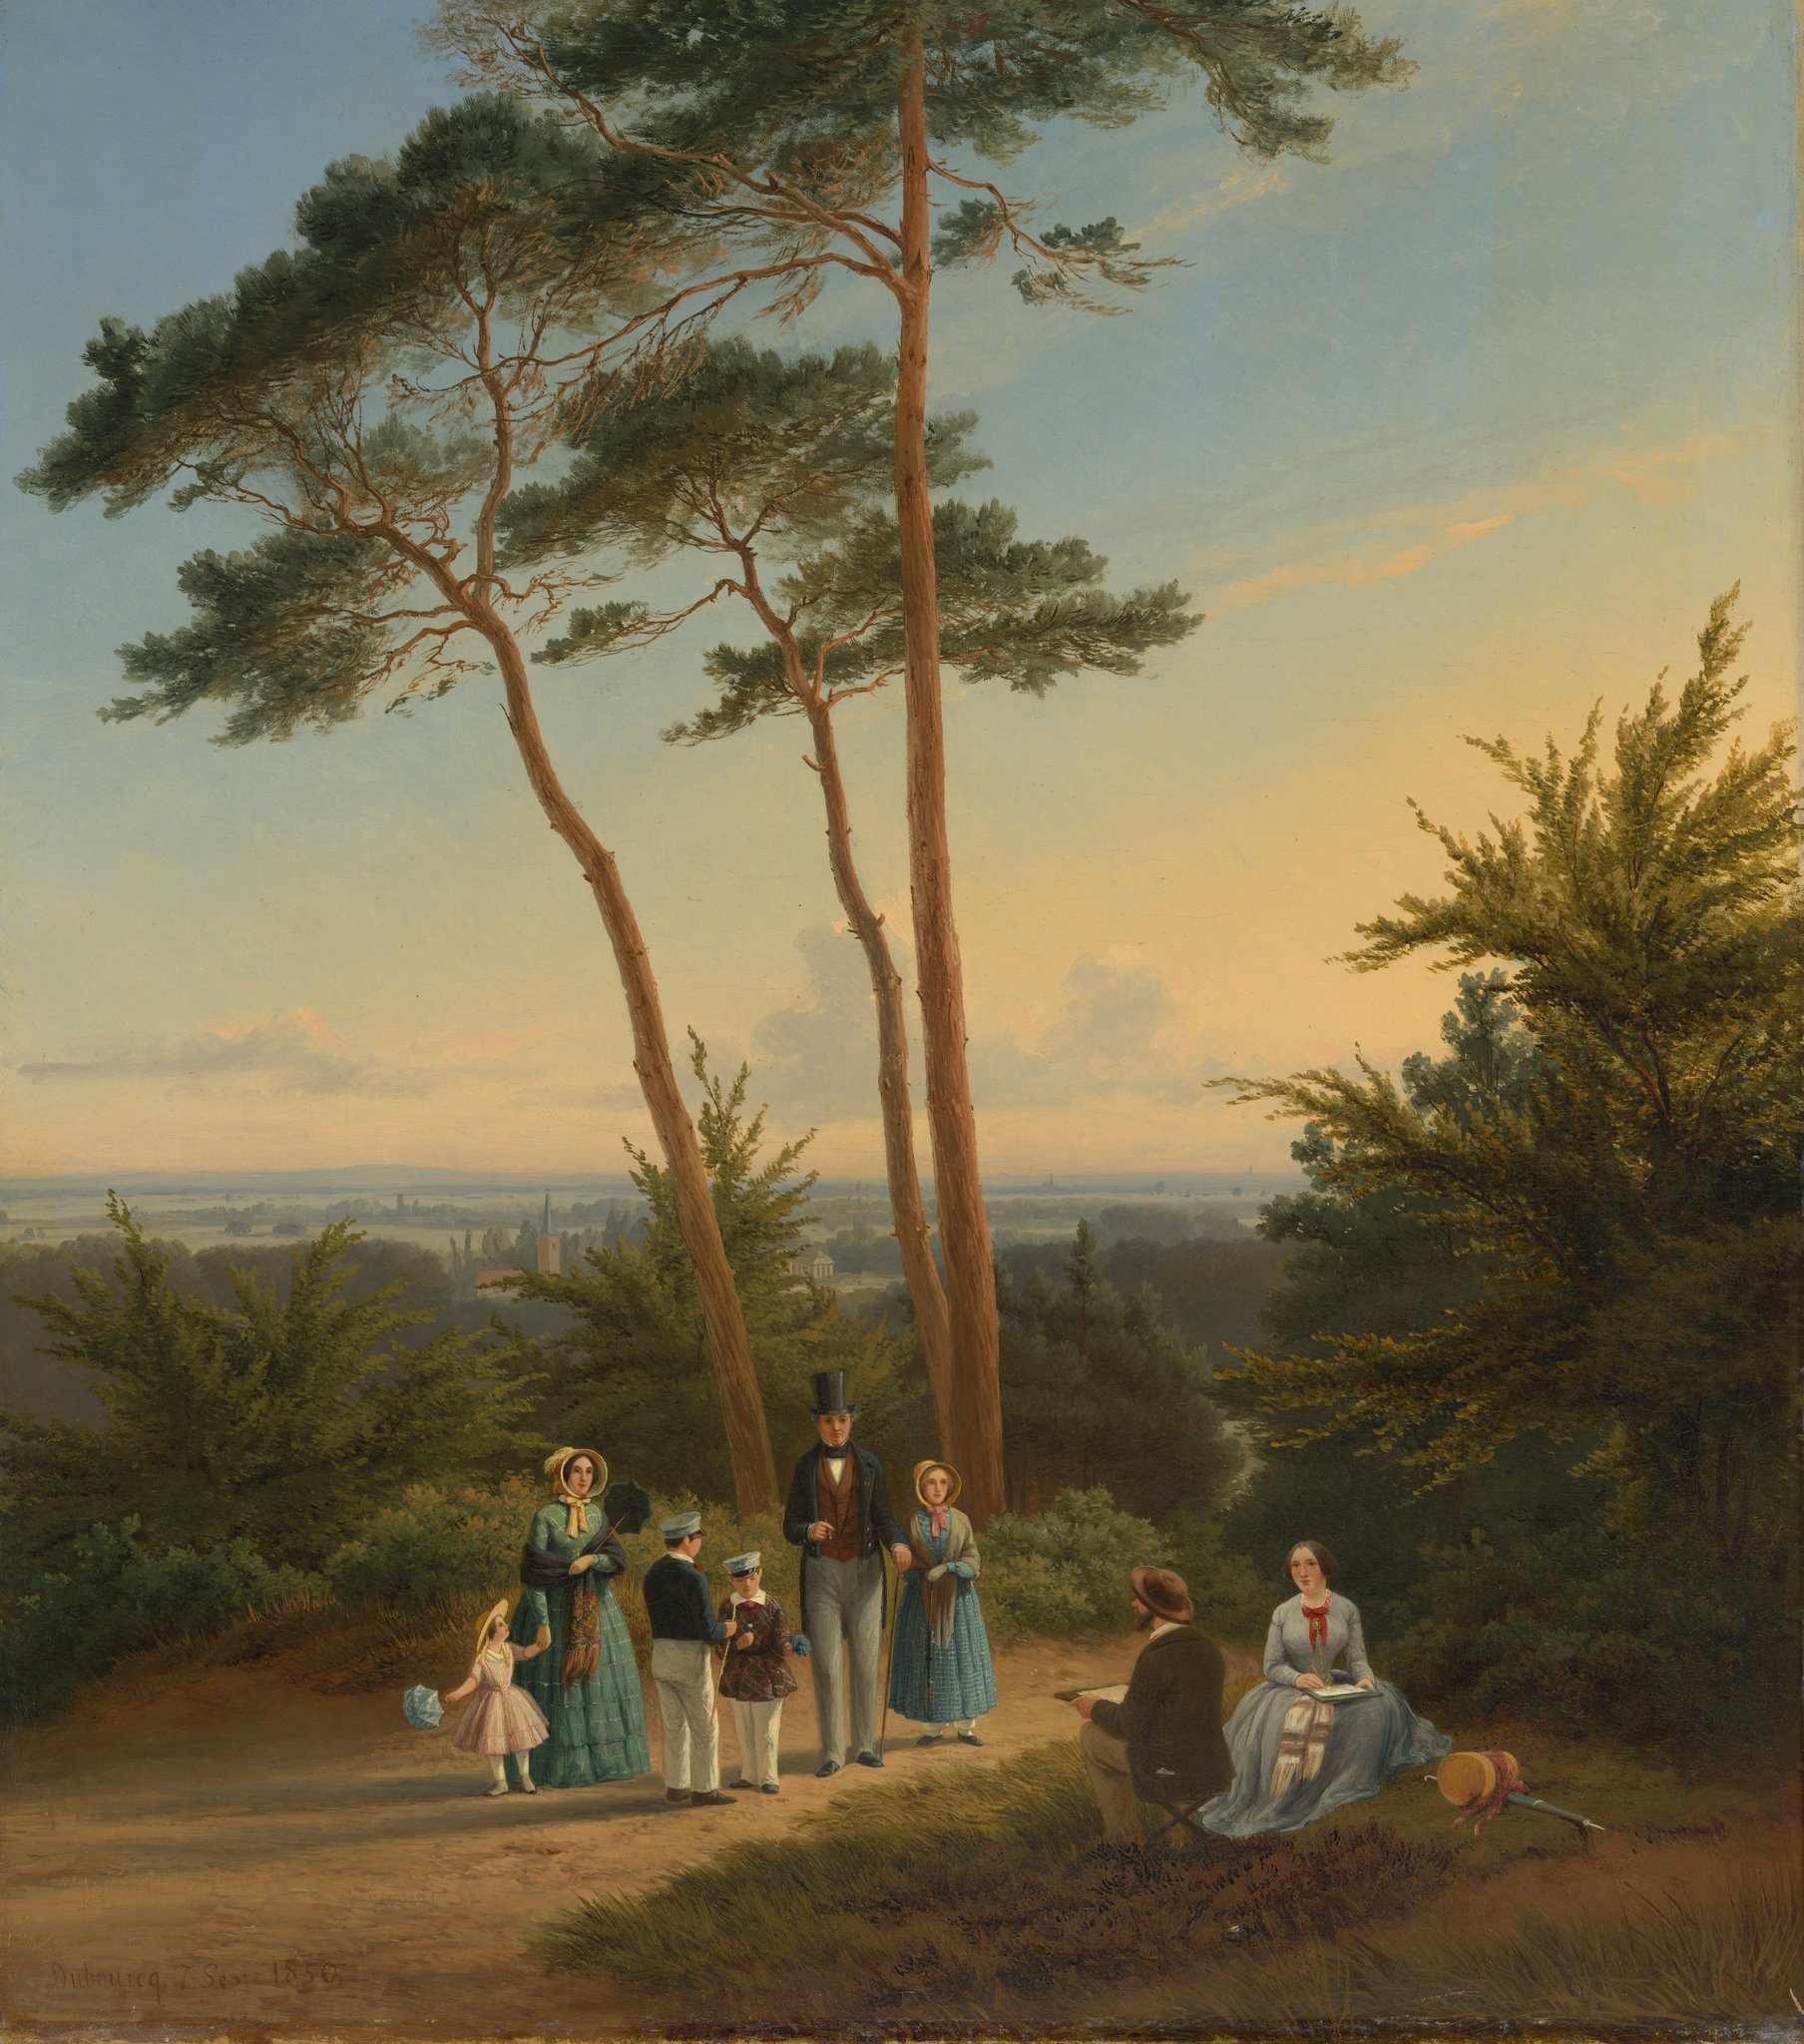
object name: painting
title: De familie van Isaac Jacobus Rochussen (1794-1881) en Hermina Johanna Maria Scharff (1808-1875) geschilderd door de kunstenaar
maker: pierre louis dubourcq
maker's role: draughtsman, painter, print maker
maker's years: 1815-1873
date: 1850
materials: canvas, oil, paint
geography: netherlands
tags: painter, print maker, draughtsman, pierre louis dubourcq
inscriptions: inscription: ‘no 80, 7 sept. 1850 / 25jarige echtvereeniging van / den welgeb heer mr JJ Rochussen / vrouw HJM Scharff’, date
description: Een gezin met vier kinderen staat stil op een landweg in een landschap. De schilder zelf zit op de voorgrond met zijn rug naar de beschouwer, hij is bezig aan een tekening, net zoals zijn toenmalige verloofde naast hem, zij is naar de beschouwer gekeerd. De scène moet gelezen worden alsof de familie de tekenaars onverwacht in het landschap treft. Het betreft de aanstaande schoonfamilie van de kunstenaar.